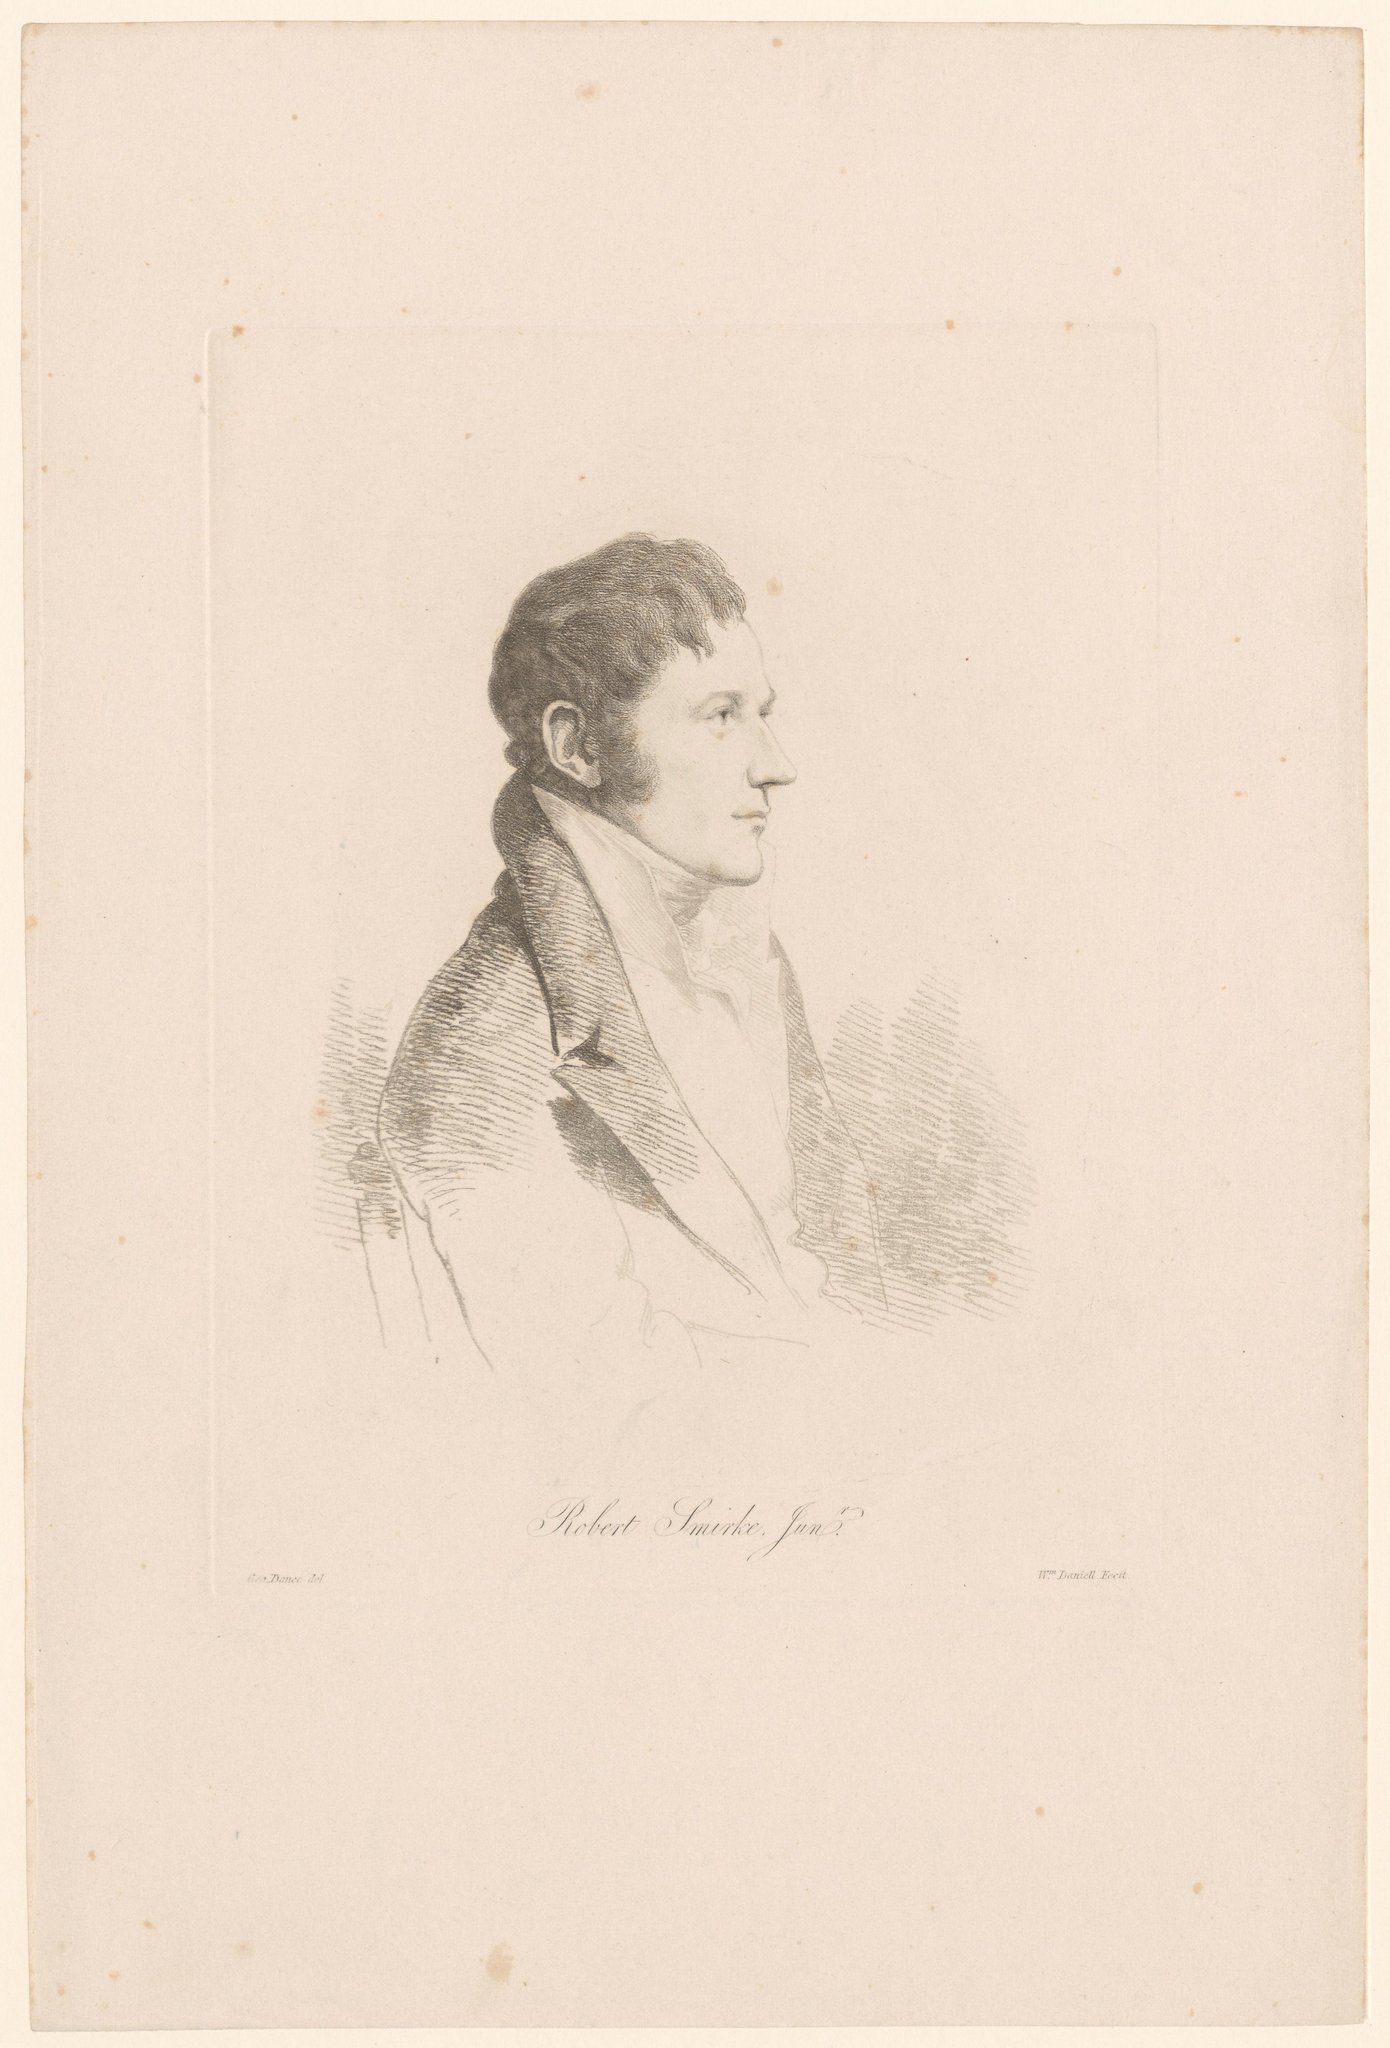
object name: print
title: Portret van Robert Smirke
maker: william daniell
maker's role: artist, print maker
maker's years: 1769-1839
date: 1779-1839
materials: paper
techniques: printmaking, etching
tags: historical persons, portrait, self-portrait of architect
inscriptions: collector's mark: Lugt 2228